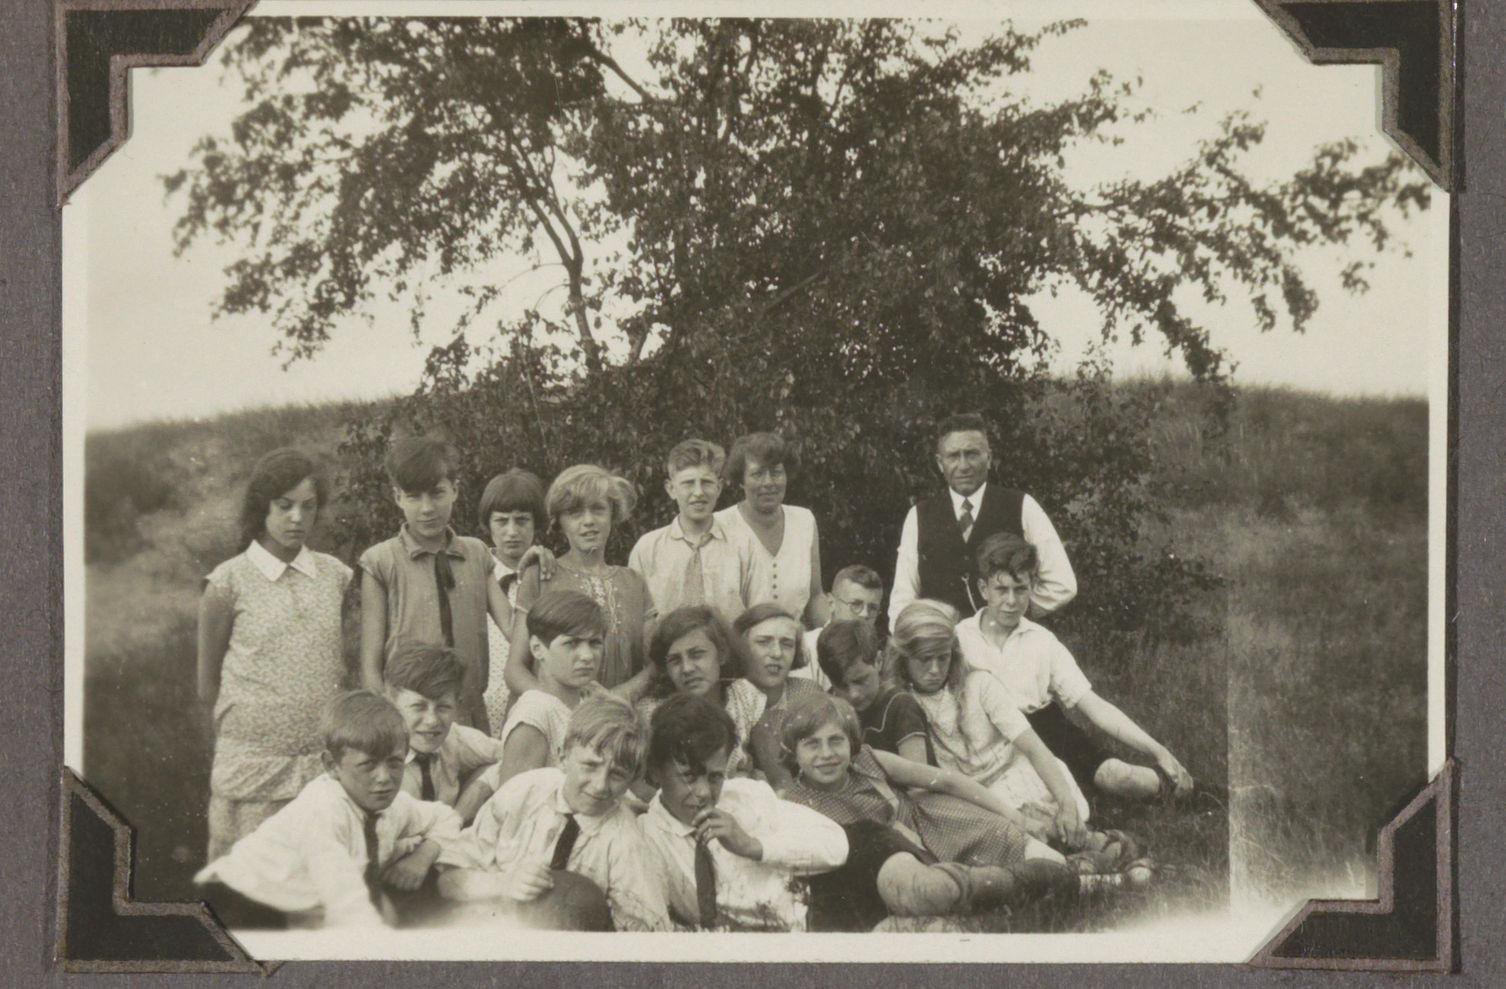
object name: photograph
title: Groepsportret van een klas en twee docenten van de Planciusschool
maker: Anonymous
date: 1930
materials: photographic support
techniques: gelatin silver print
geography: netherlands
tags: teacher and pupil, elementary school; class, form, netherlands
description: Onderdeel van Fotoalbum met opnames van vakanties in Zuid-Frankrijk.